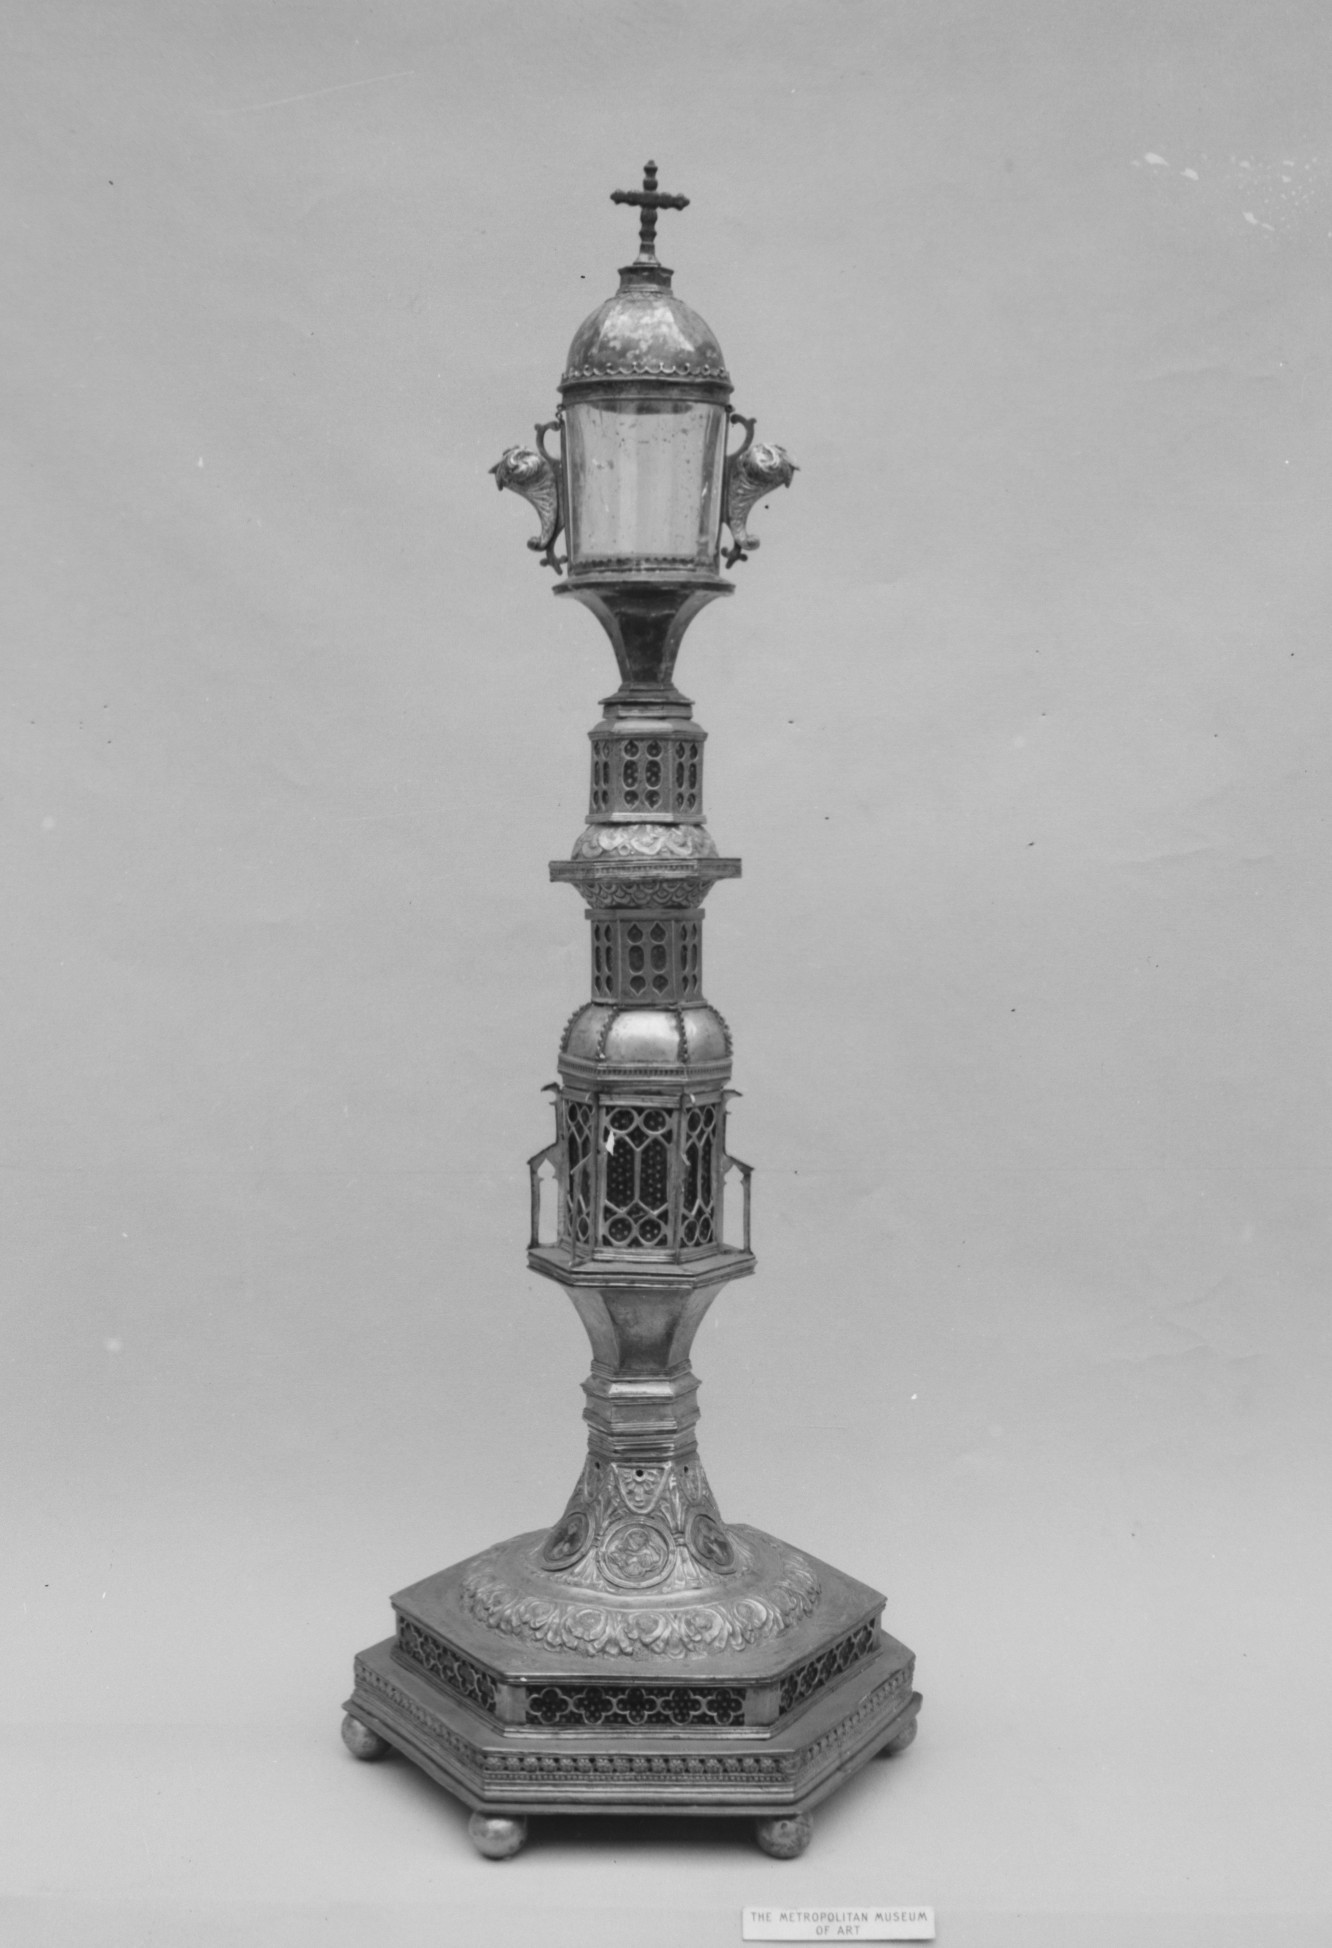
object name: reliquary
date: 1401-1500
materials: gilt copper, enamel, silver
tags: cross,reliquaries